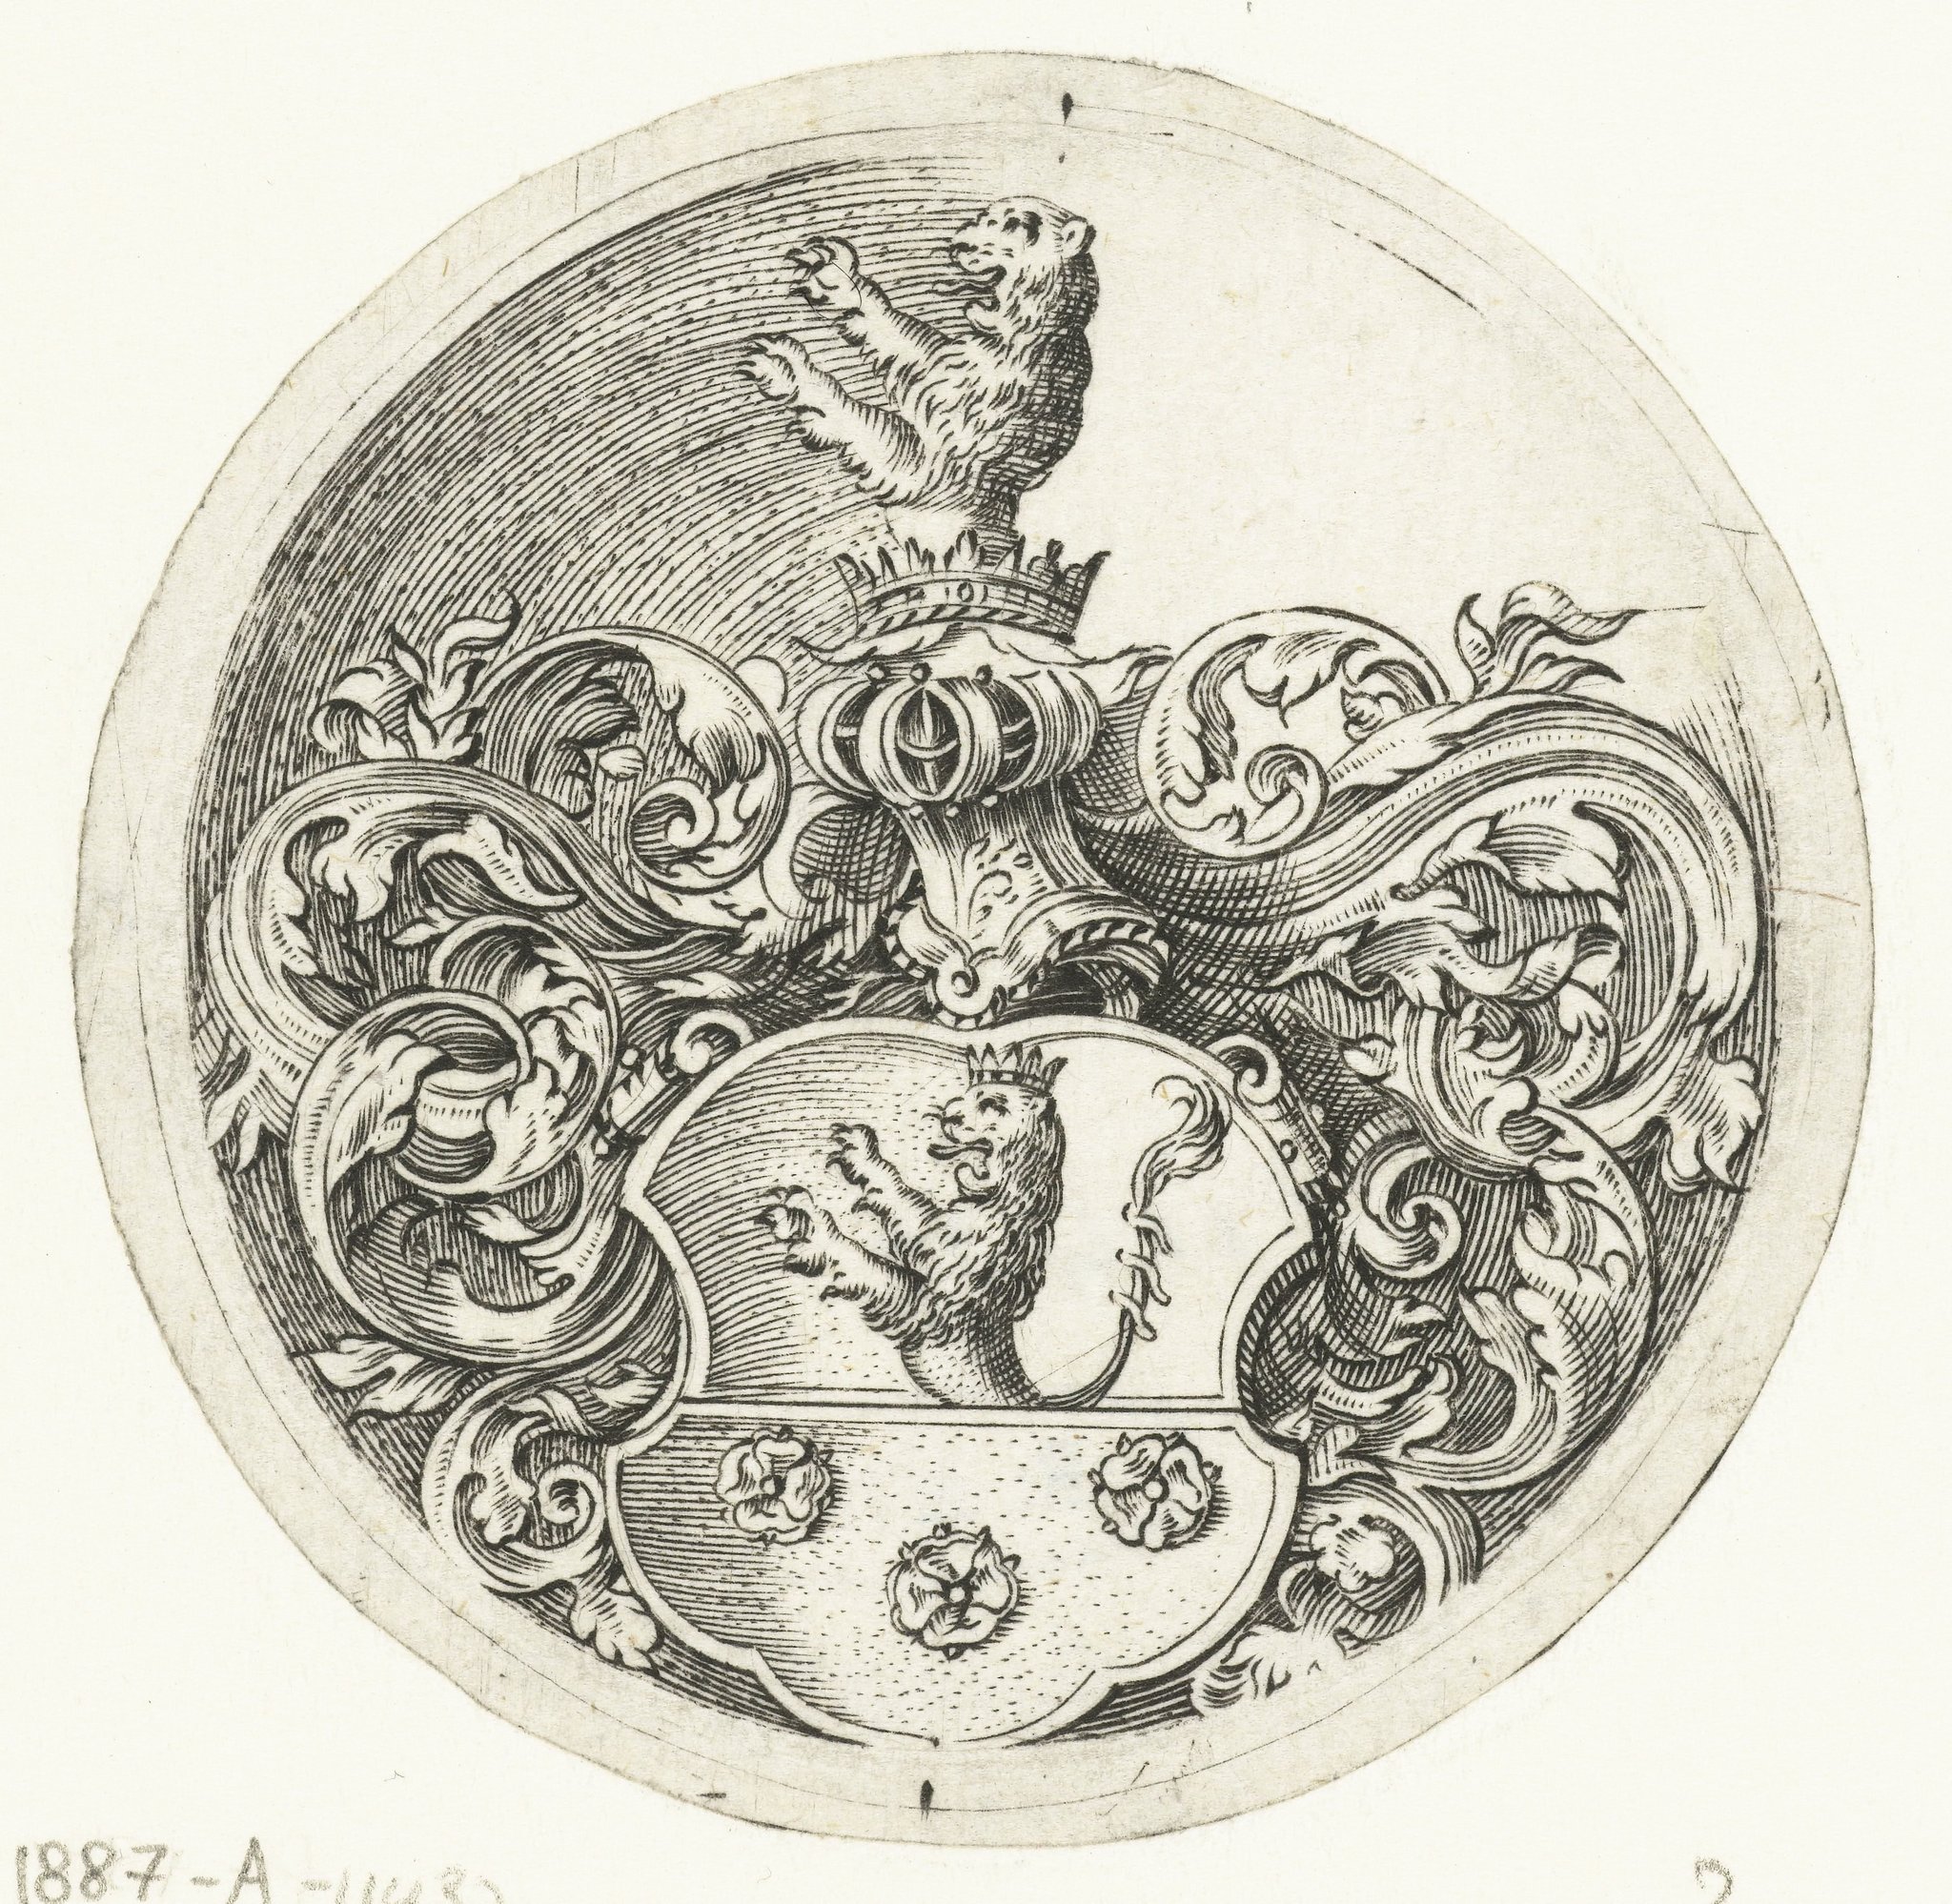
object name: print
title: Wapenschild met een leeuw en drie rozen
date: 1597-1656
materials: paper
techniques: engraving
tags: flowers: rose, beasts of prey, predatory animals: lion, armorial bearing, heraldry